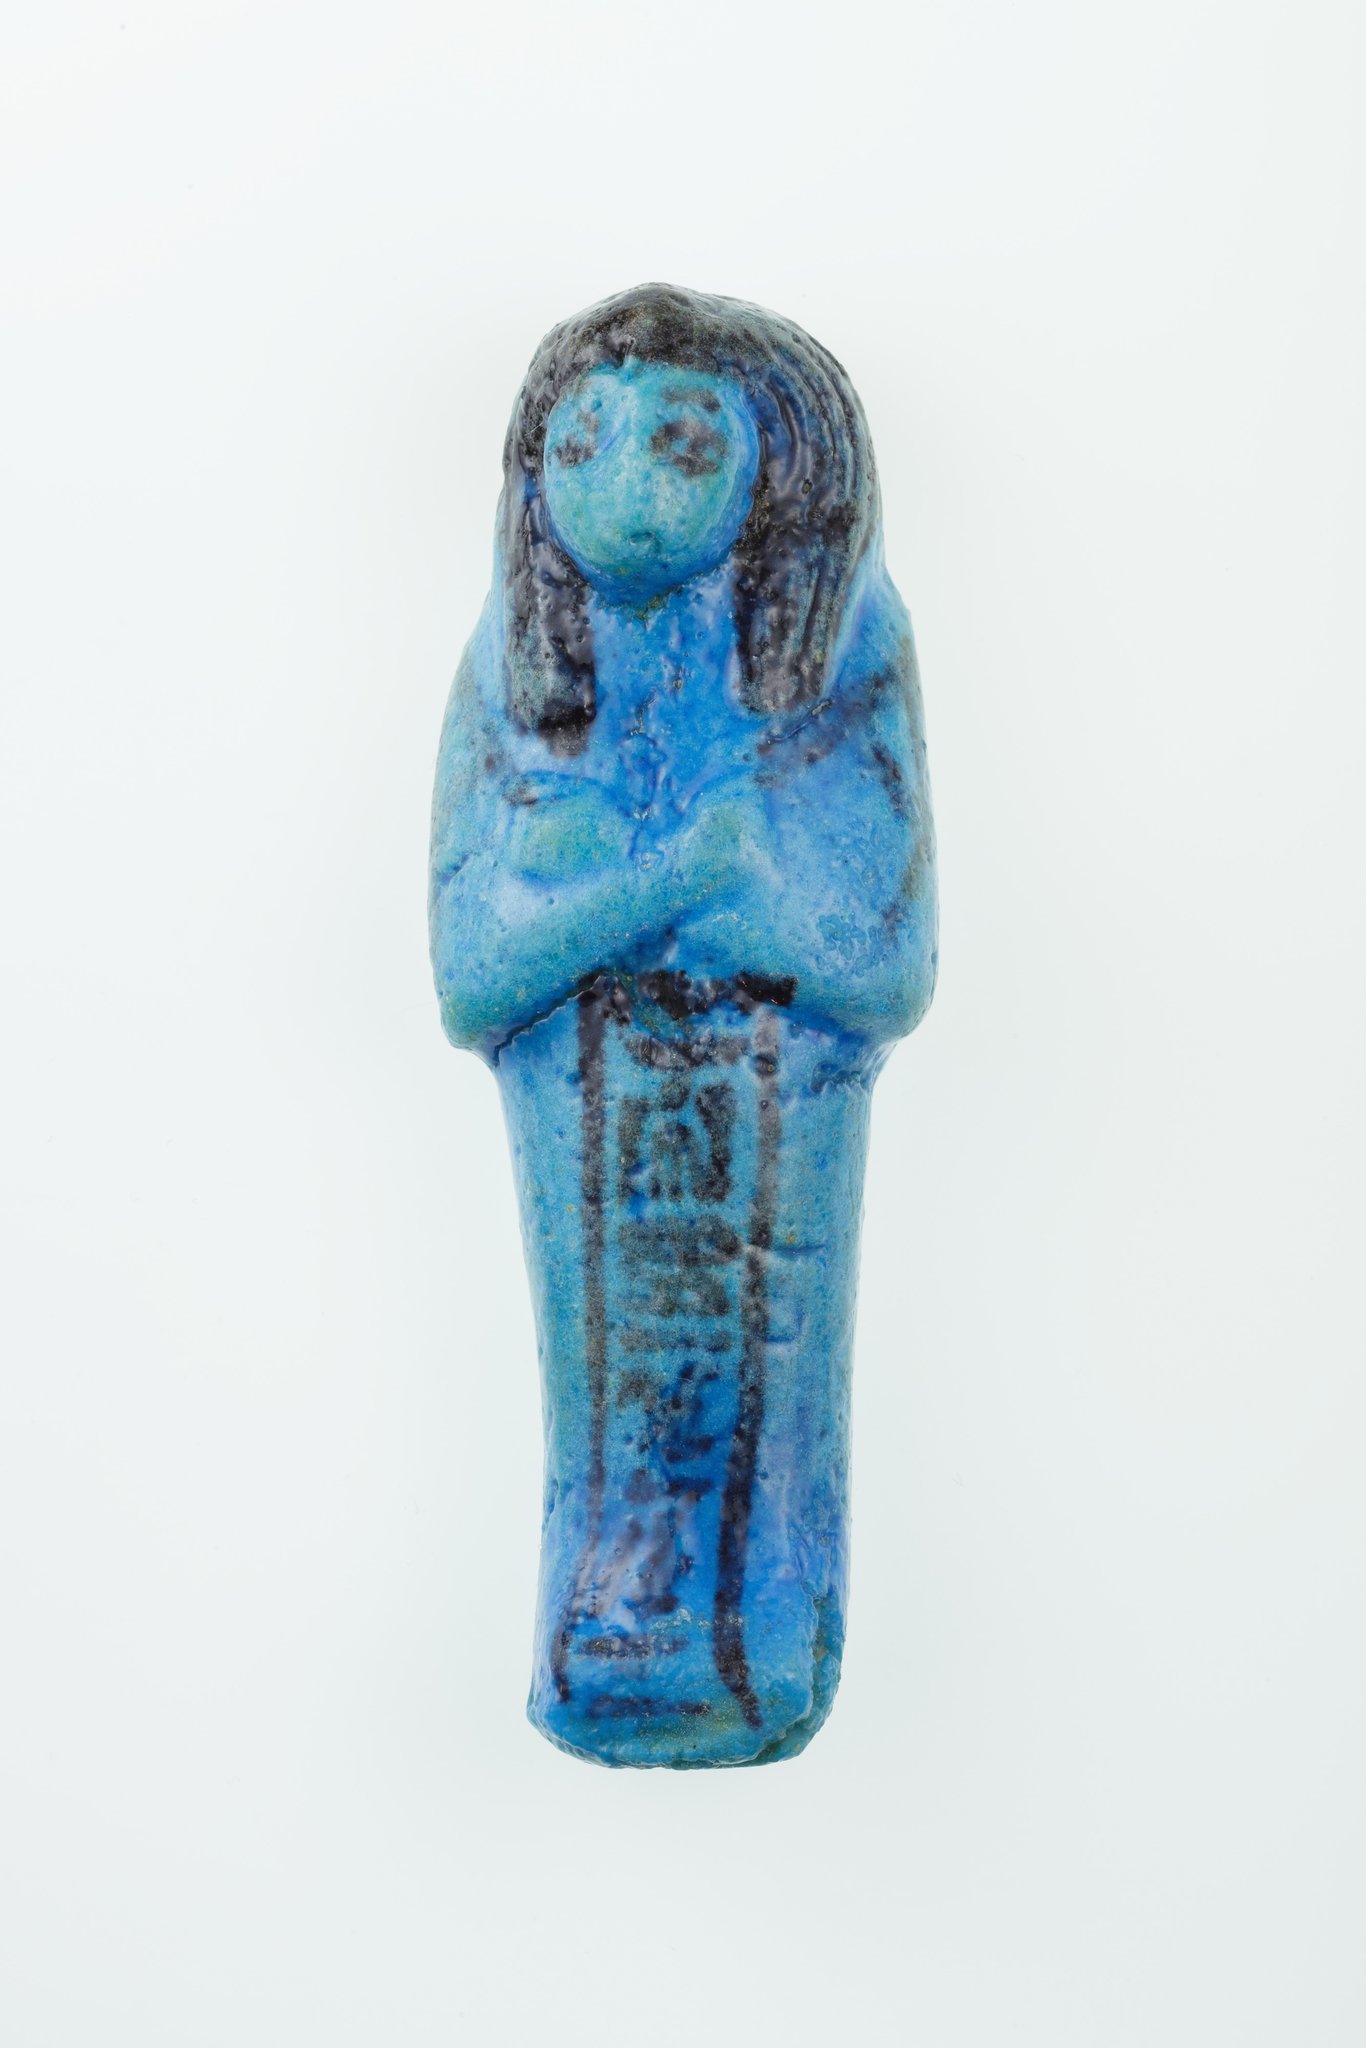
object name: shabti, worker, nauny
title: Worker Shabti of Nauny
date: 1050 BCE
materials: faience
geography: egypt